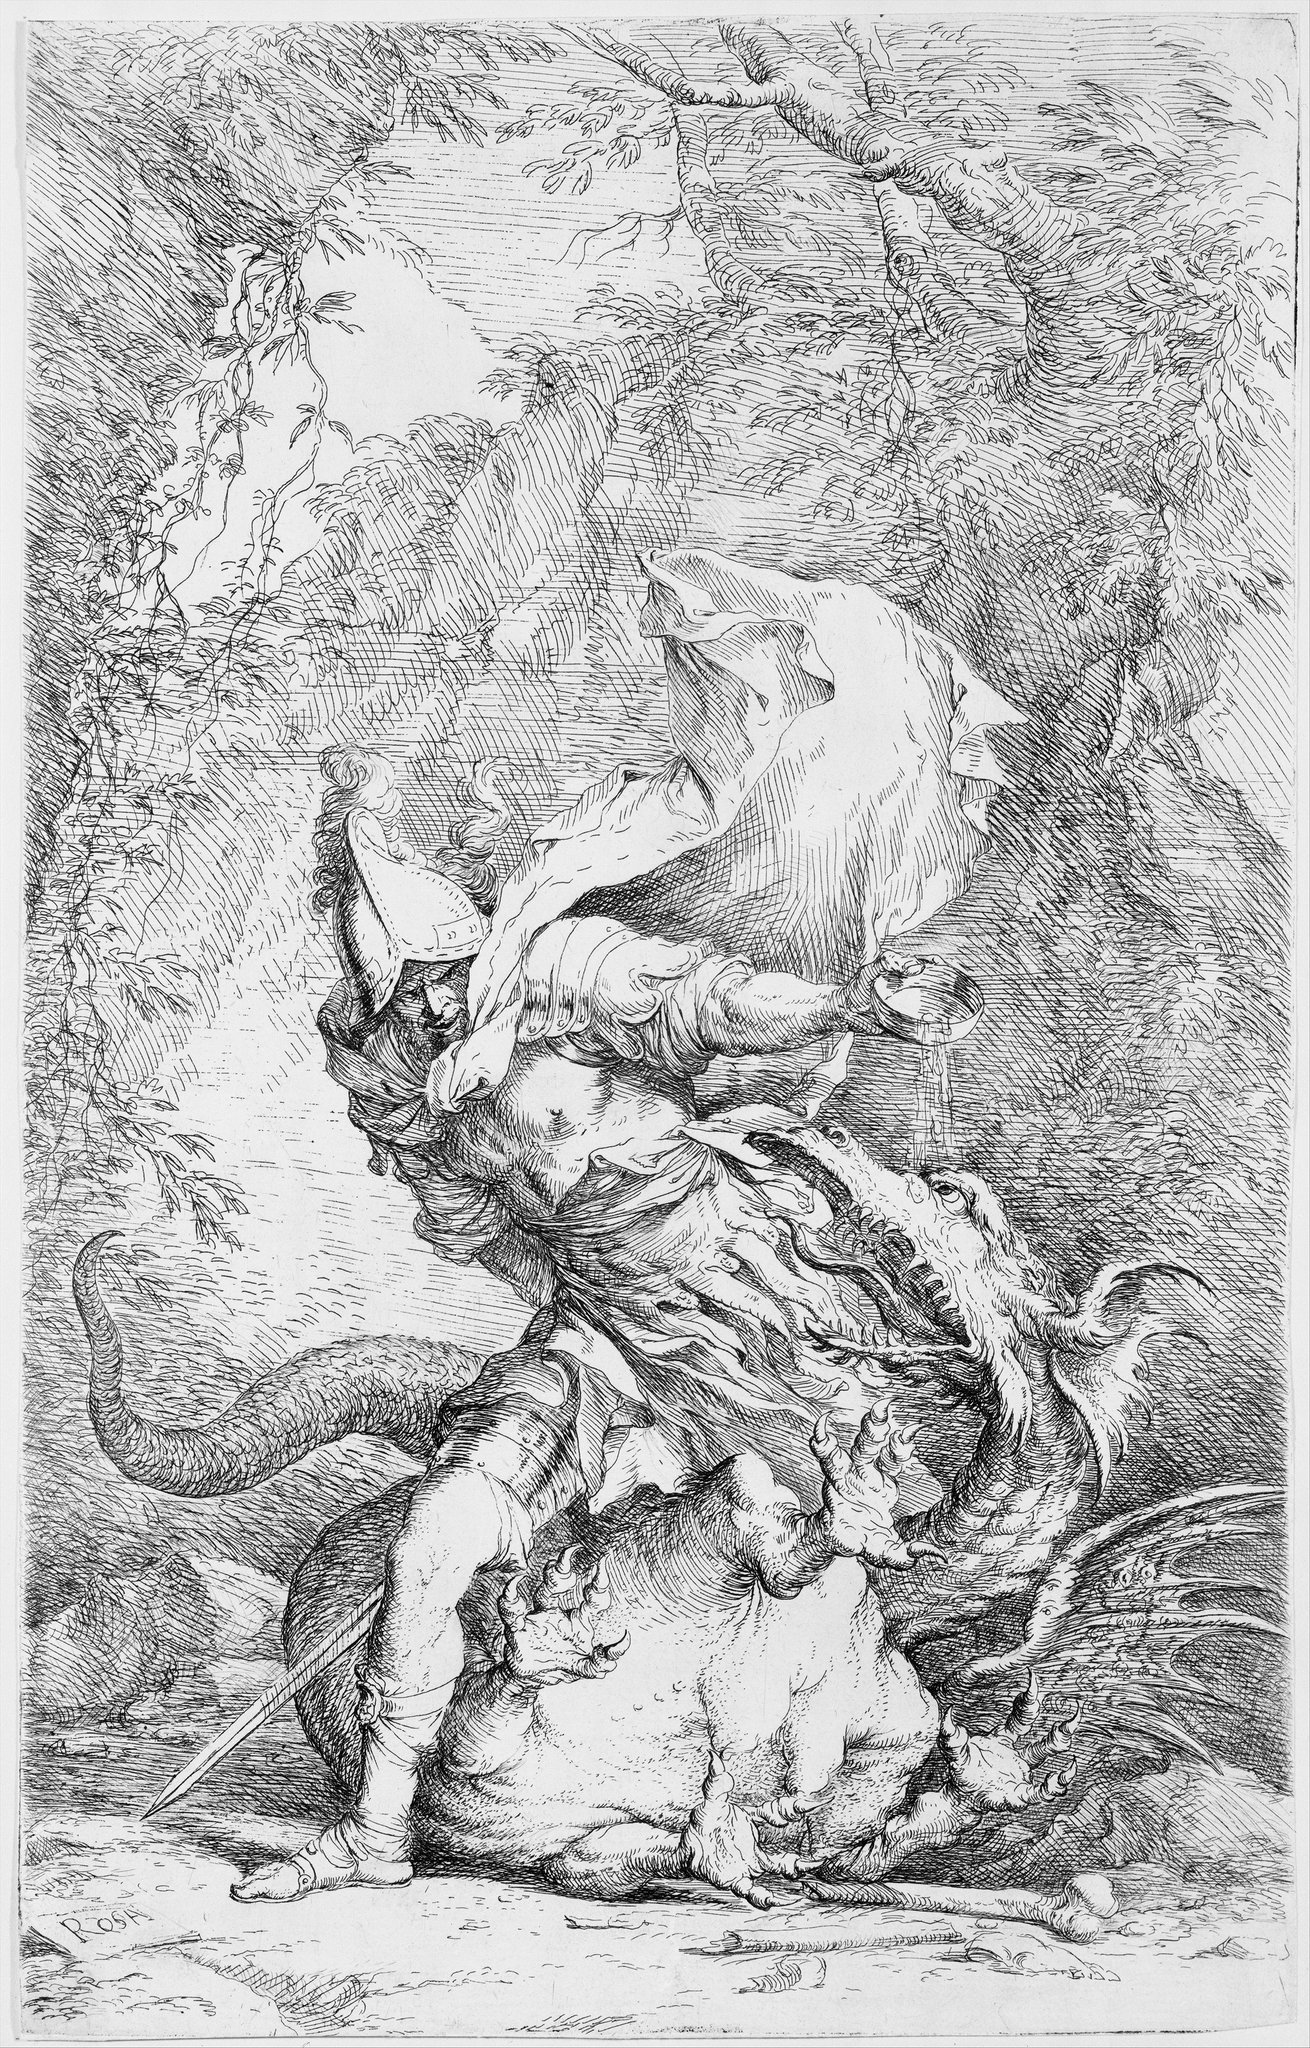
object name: print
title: Jason and the Dragon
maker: salvator rosa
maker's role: artist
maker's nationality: italian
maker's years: 1615-1673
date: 1663-1664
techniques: drypoint, etching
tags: men,dragons,trees